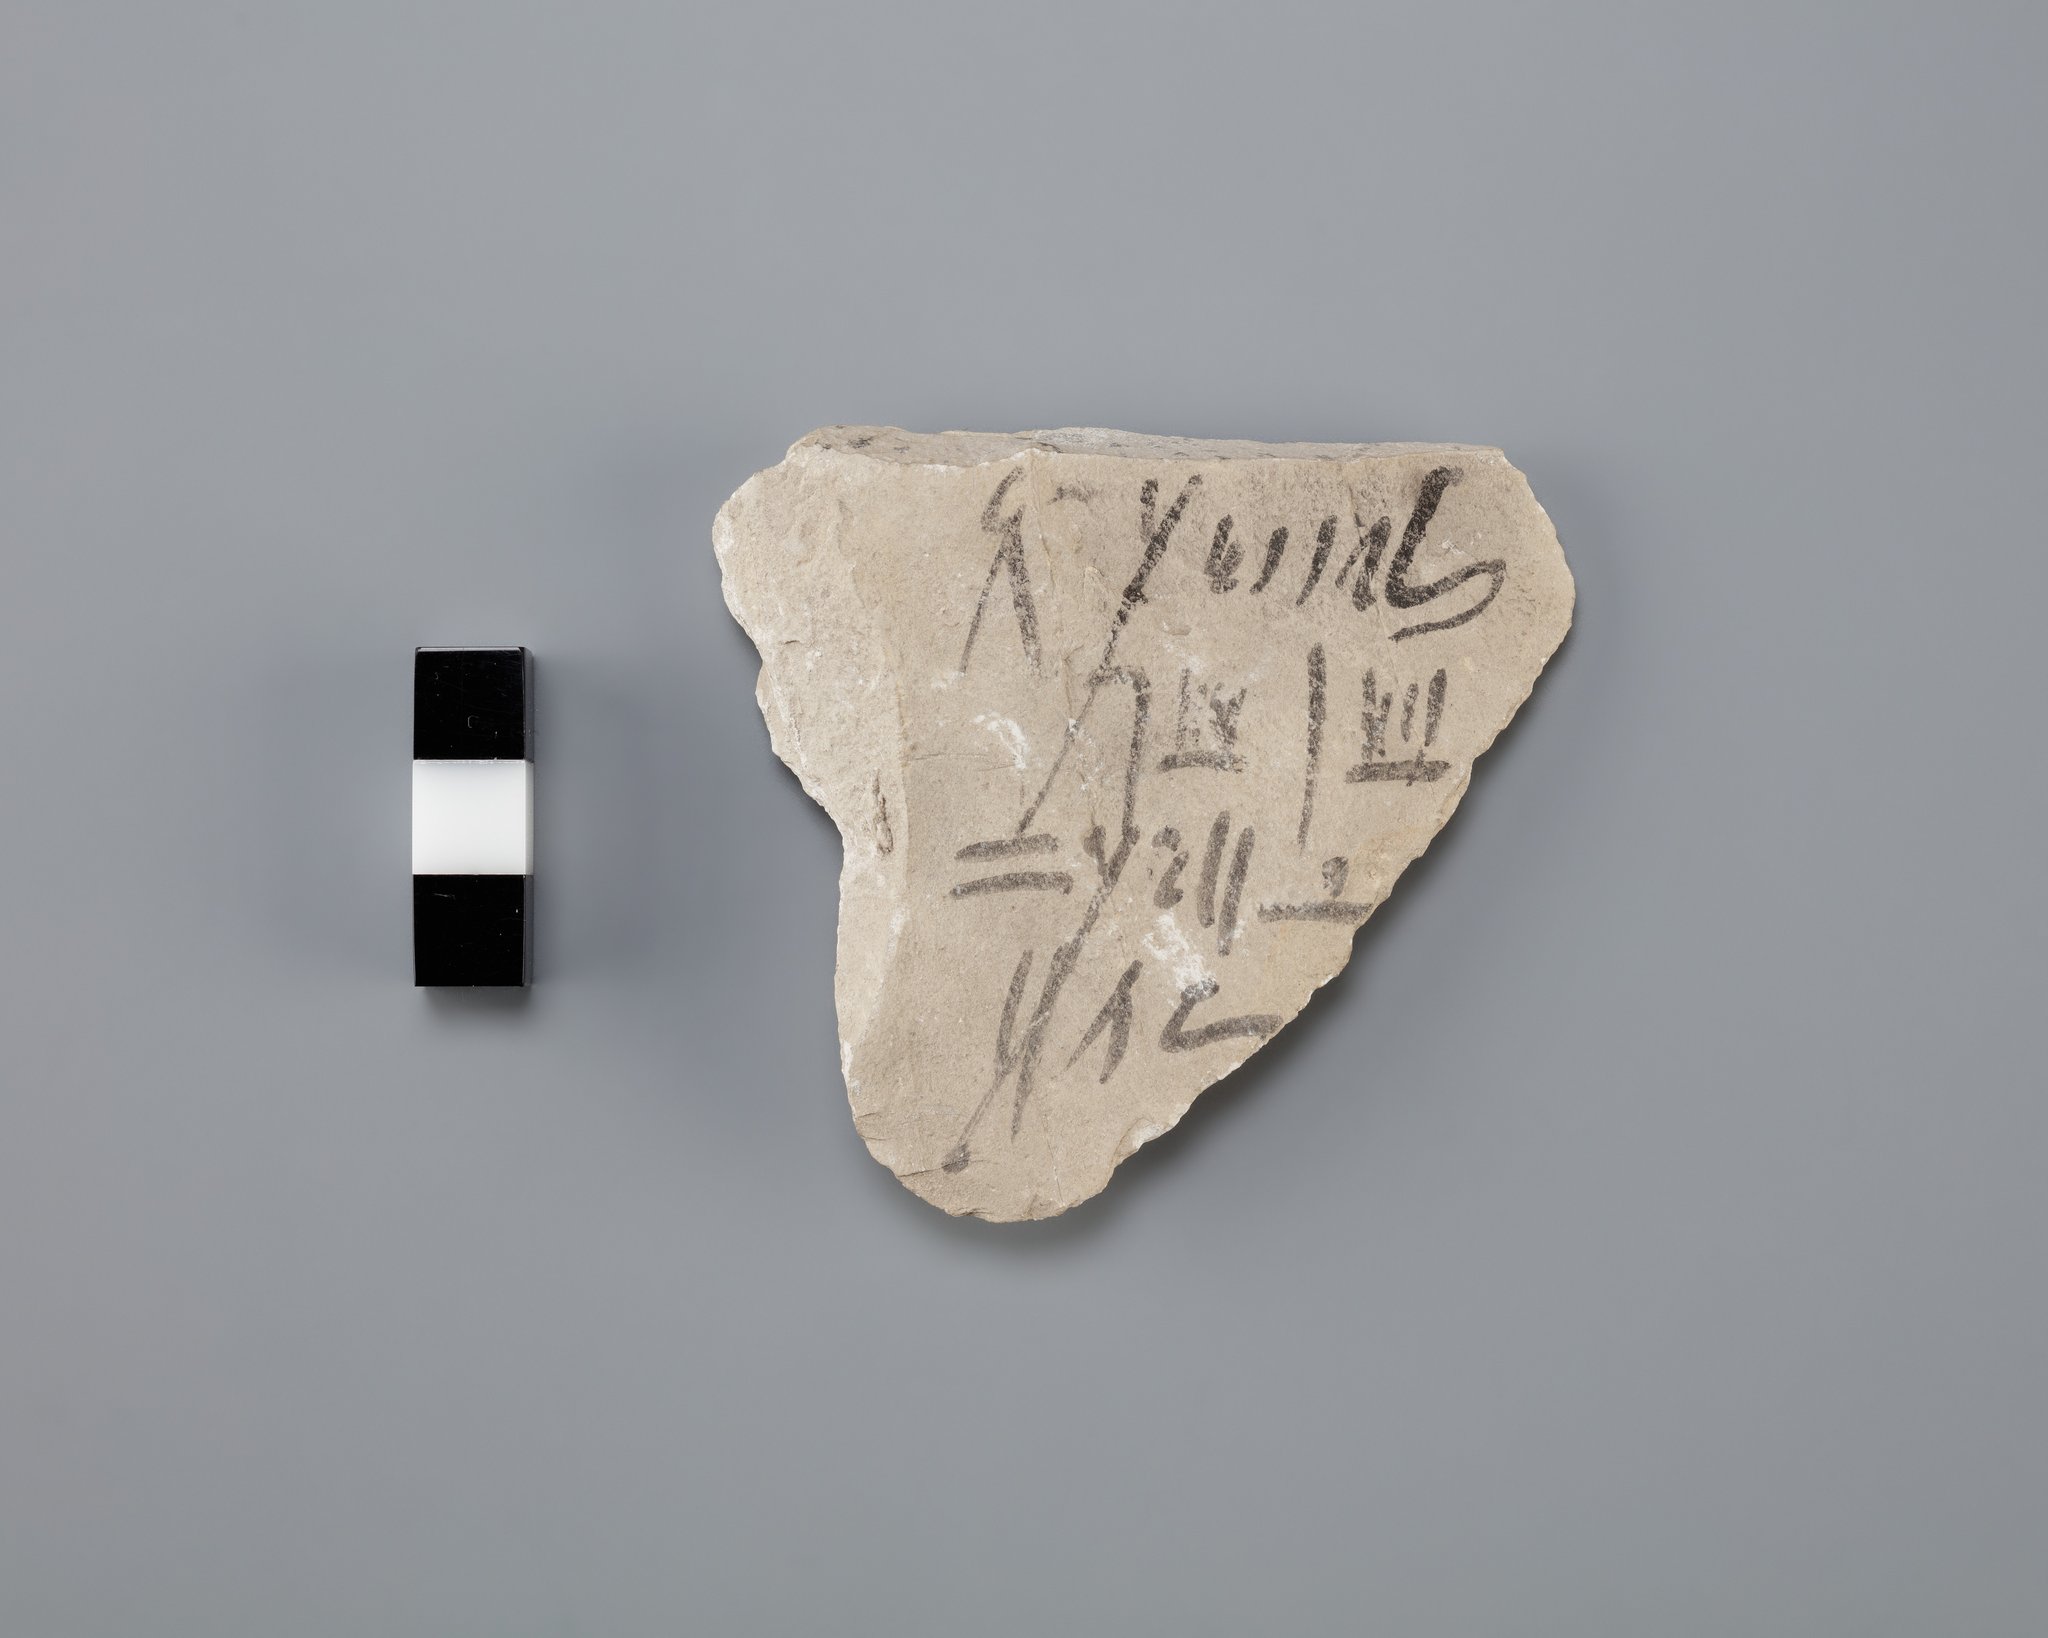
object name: ostracon, hieratic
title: Hieratic ostracon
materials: ink, limestone, paint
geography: egypt